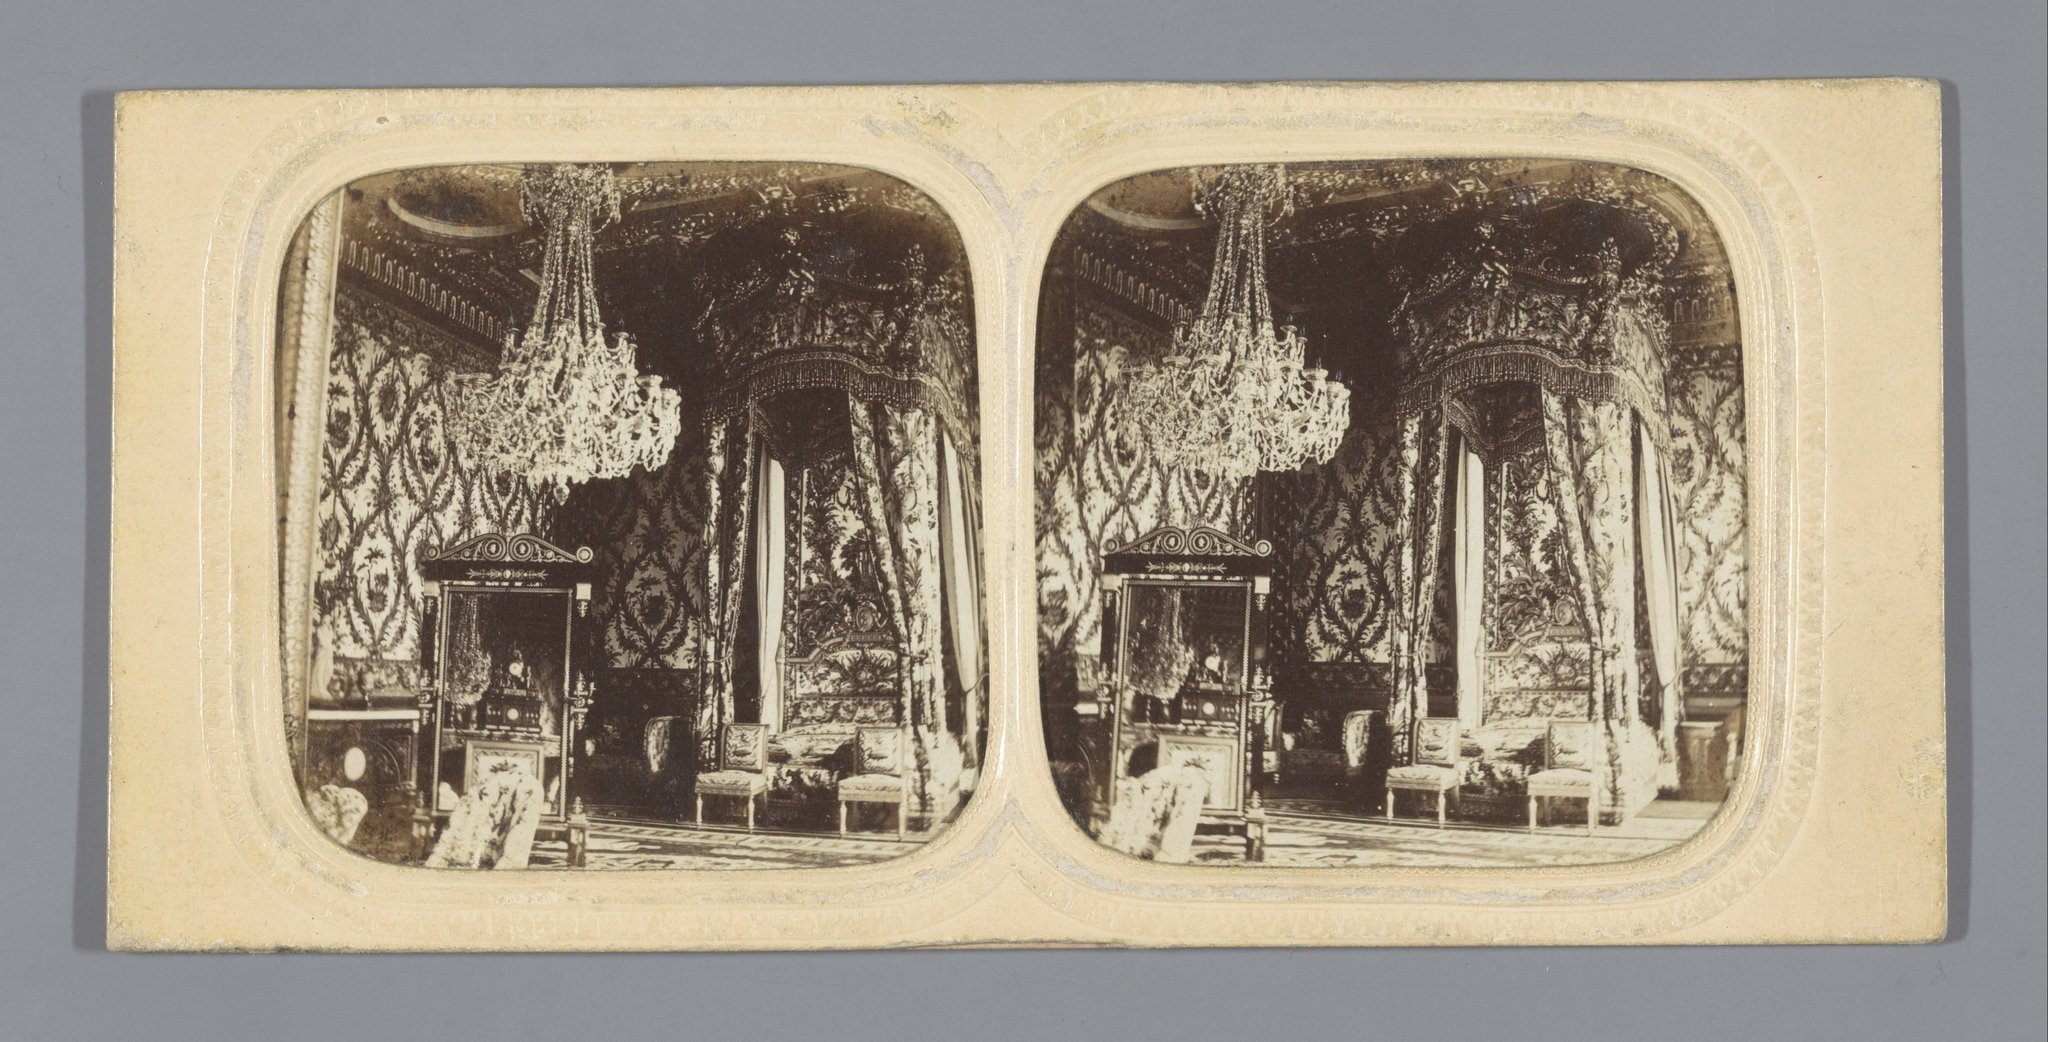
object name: tissue stereograph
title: Palais de fontainebleau, Chambre de l'imperatrice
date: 1855-1875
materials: cardboard, paper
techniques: albumen print, hand coloring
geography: cologne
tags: bedroom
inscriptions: number: ‘15’, retailer's mark: ‘Stereoscopbilder/ in reicher Auswahl in/ der/ Kunsthandlung/ von/ Joh. Heinrigs in Cöln./ Hochstrasse No. 152.’, inscription: ‘D’